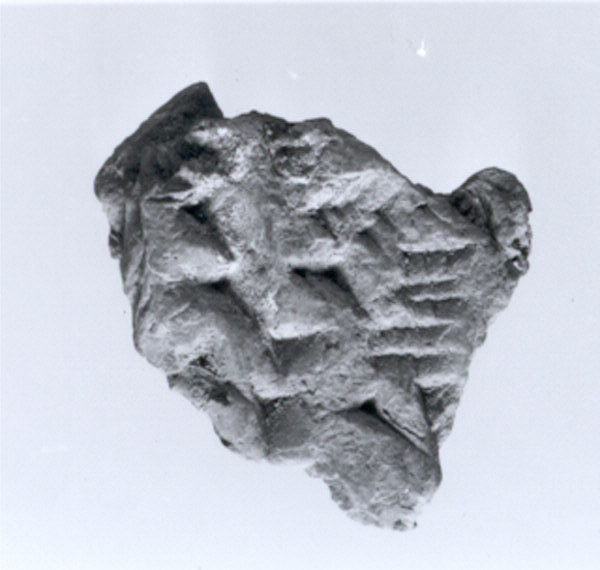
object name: cuneiform tablet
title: Cuneiform tablet: fragment of a table of reciprocals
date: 333-1 BCE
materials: clay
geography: mesopotamia